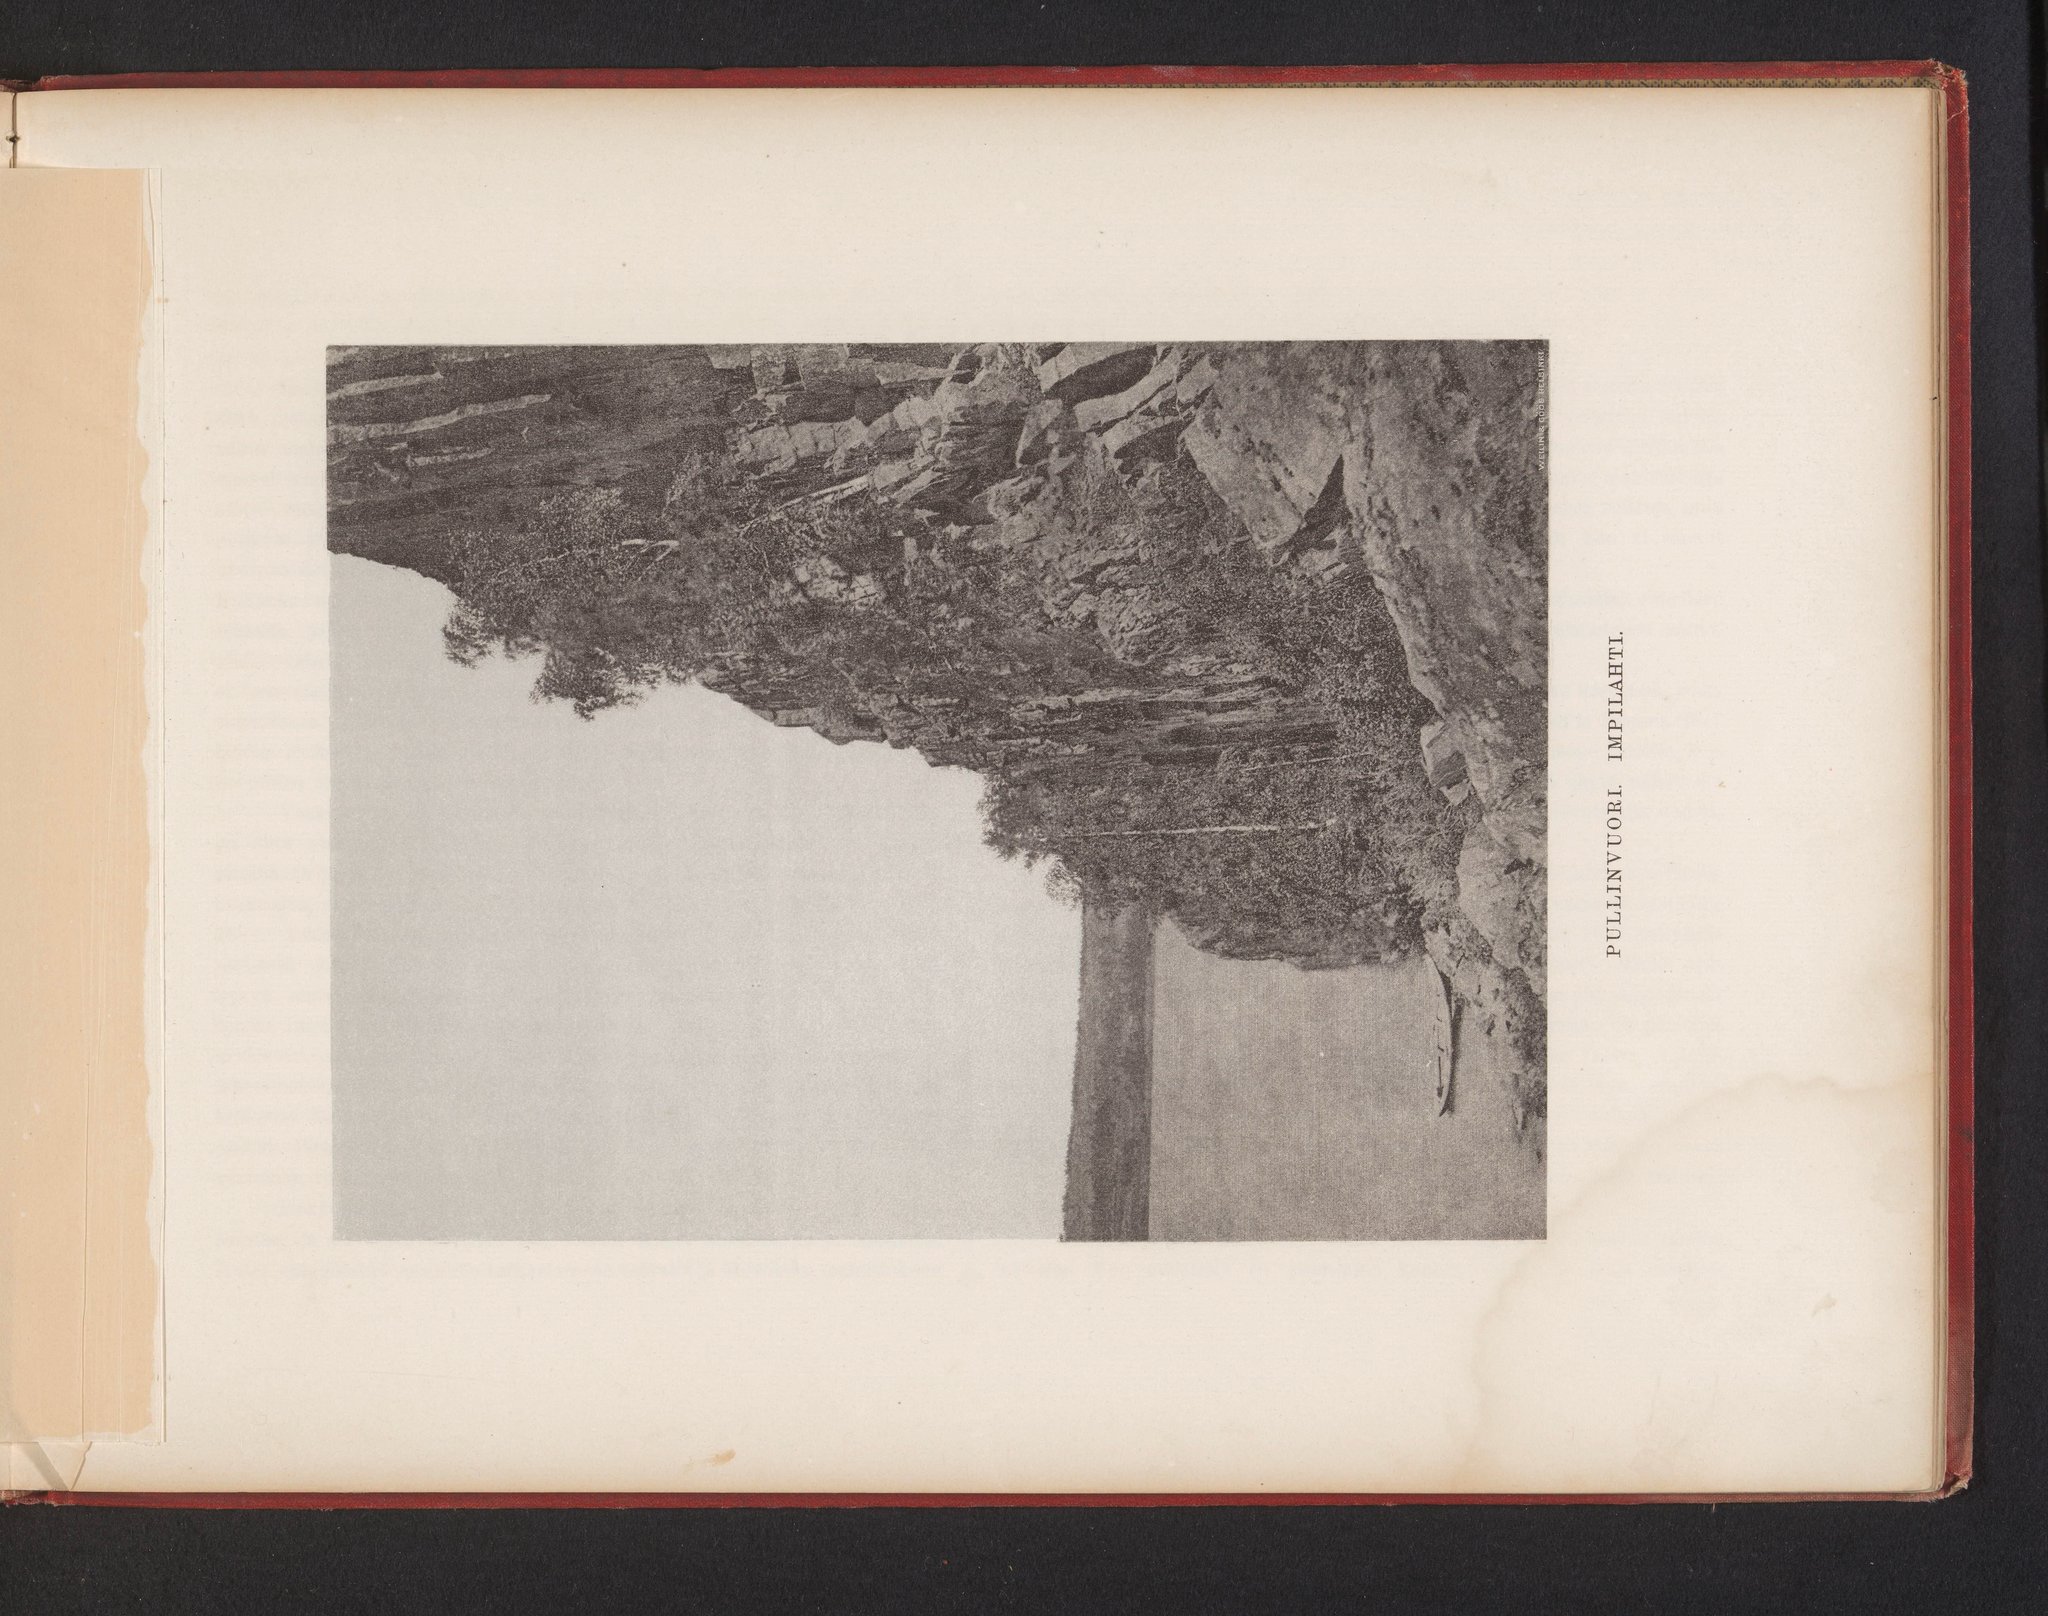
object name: page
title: Pullinvuori Impilahti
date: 1888-1893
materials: paper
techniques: autotype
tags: landscapes with waters, waterscapes, seascapes (in the temperate zone), rowing-boat, canoe, etc., rock-formations